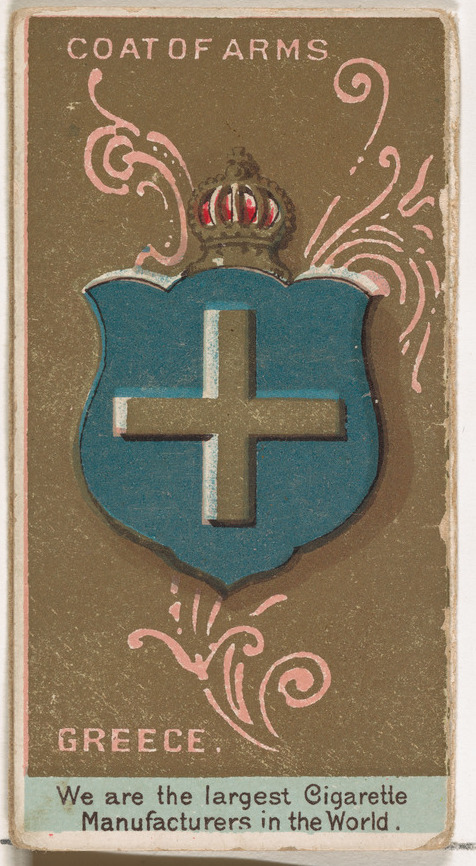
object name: print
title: George I, King of Greece, from the Rulers, Flags, and Coats of Arms series (N126-2) issued by W. Duke, Sons & Co.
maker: w. duke, sons & co.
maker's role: publisher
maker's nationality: american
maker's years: 1870-1920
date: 1888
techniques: color lithograph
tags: men,portraits,women,coat of arms,flags